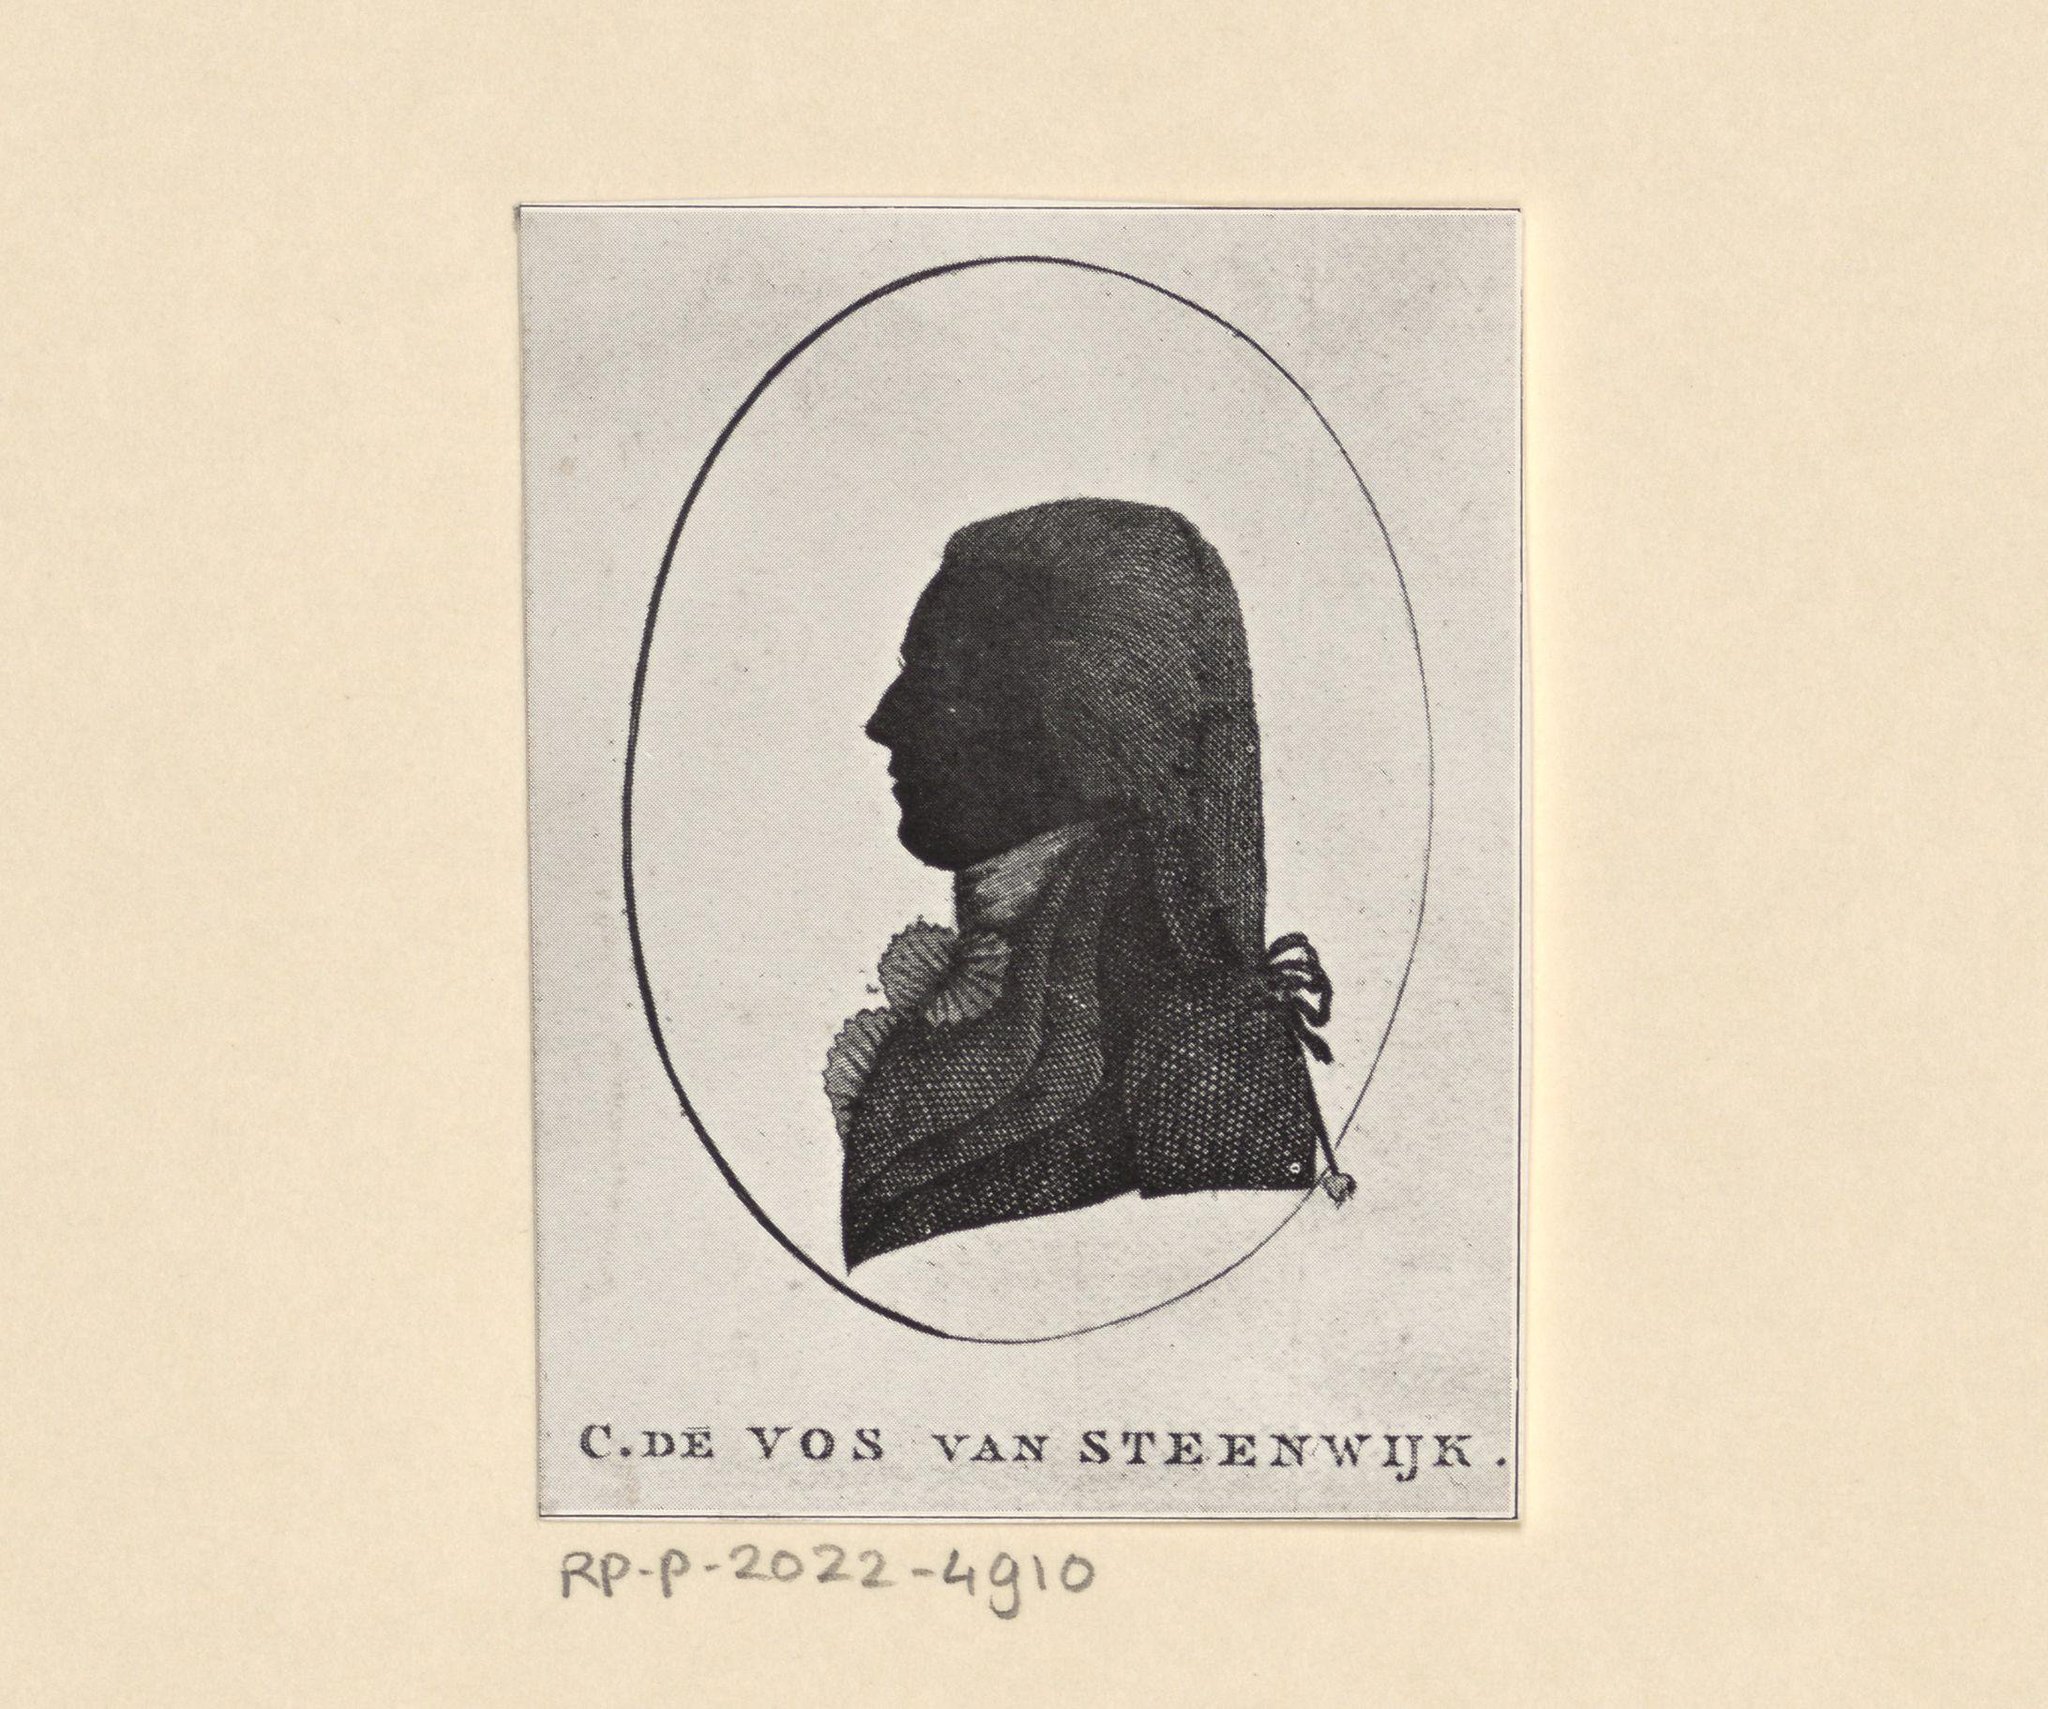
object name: print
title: Silhouetportret van Carel de Vos van Steenwijk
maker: Anonymous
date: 1799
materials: paper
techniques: etching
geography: northern netherlands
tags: official; civil servant; functionary (in general), historical persons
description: Prent waarschijnlijk uit: Rogge, Cornelis. Geschiedenis der staatsregeling, voor het Bataafsche volk. Amsterdam: Johannes Allart, 1799.